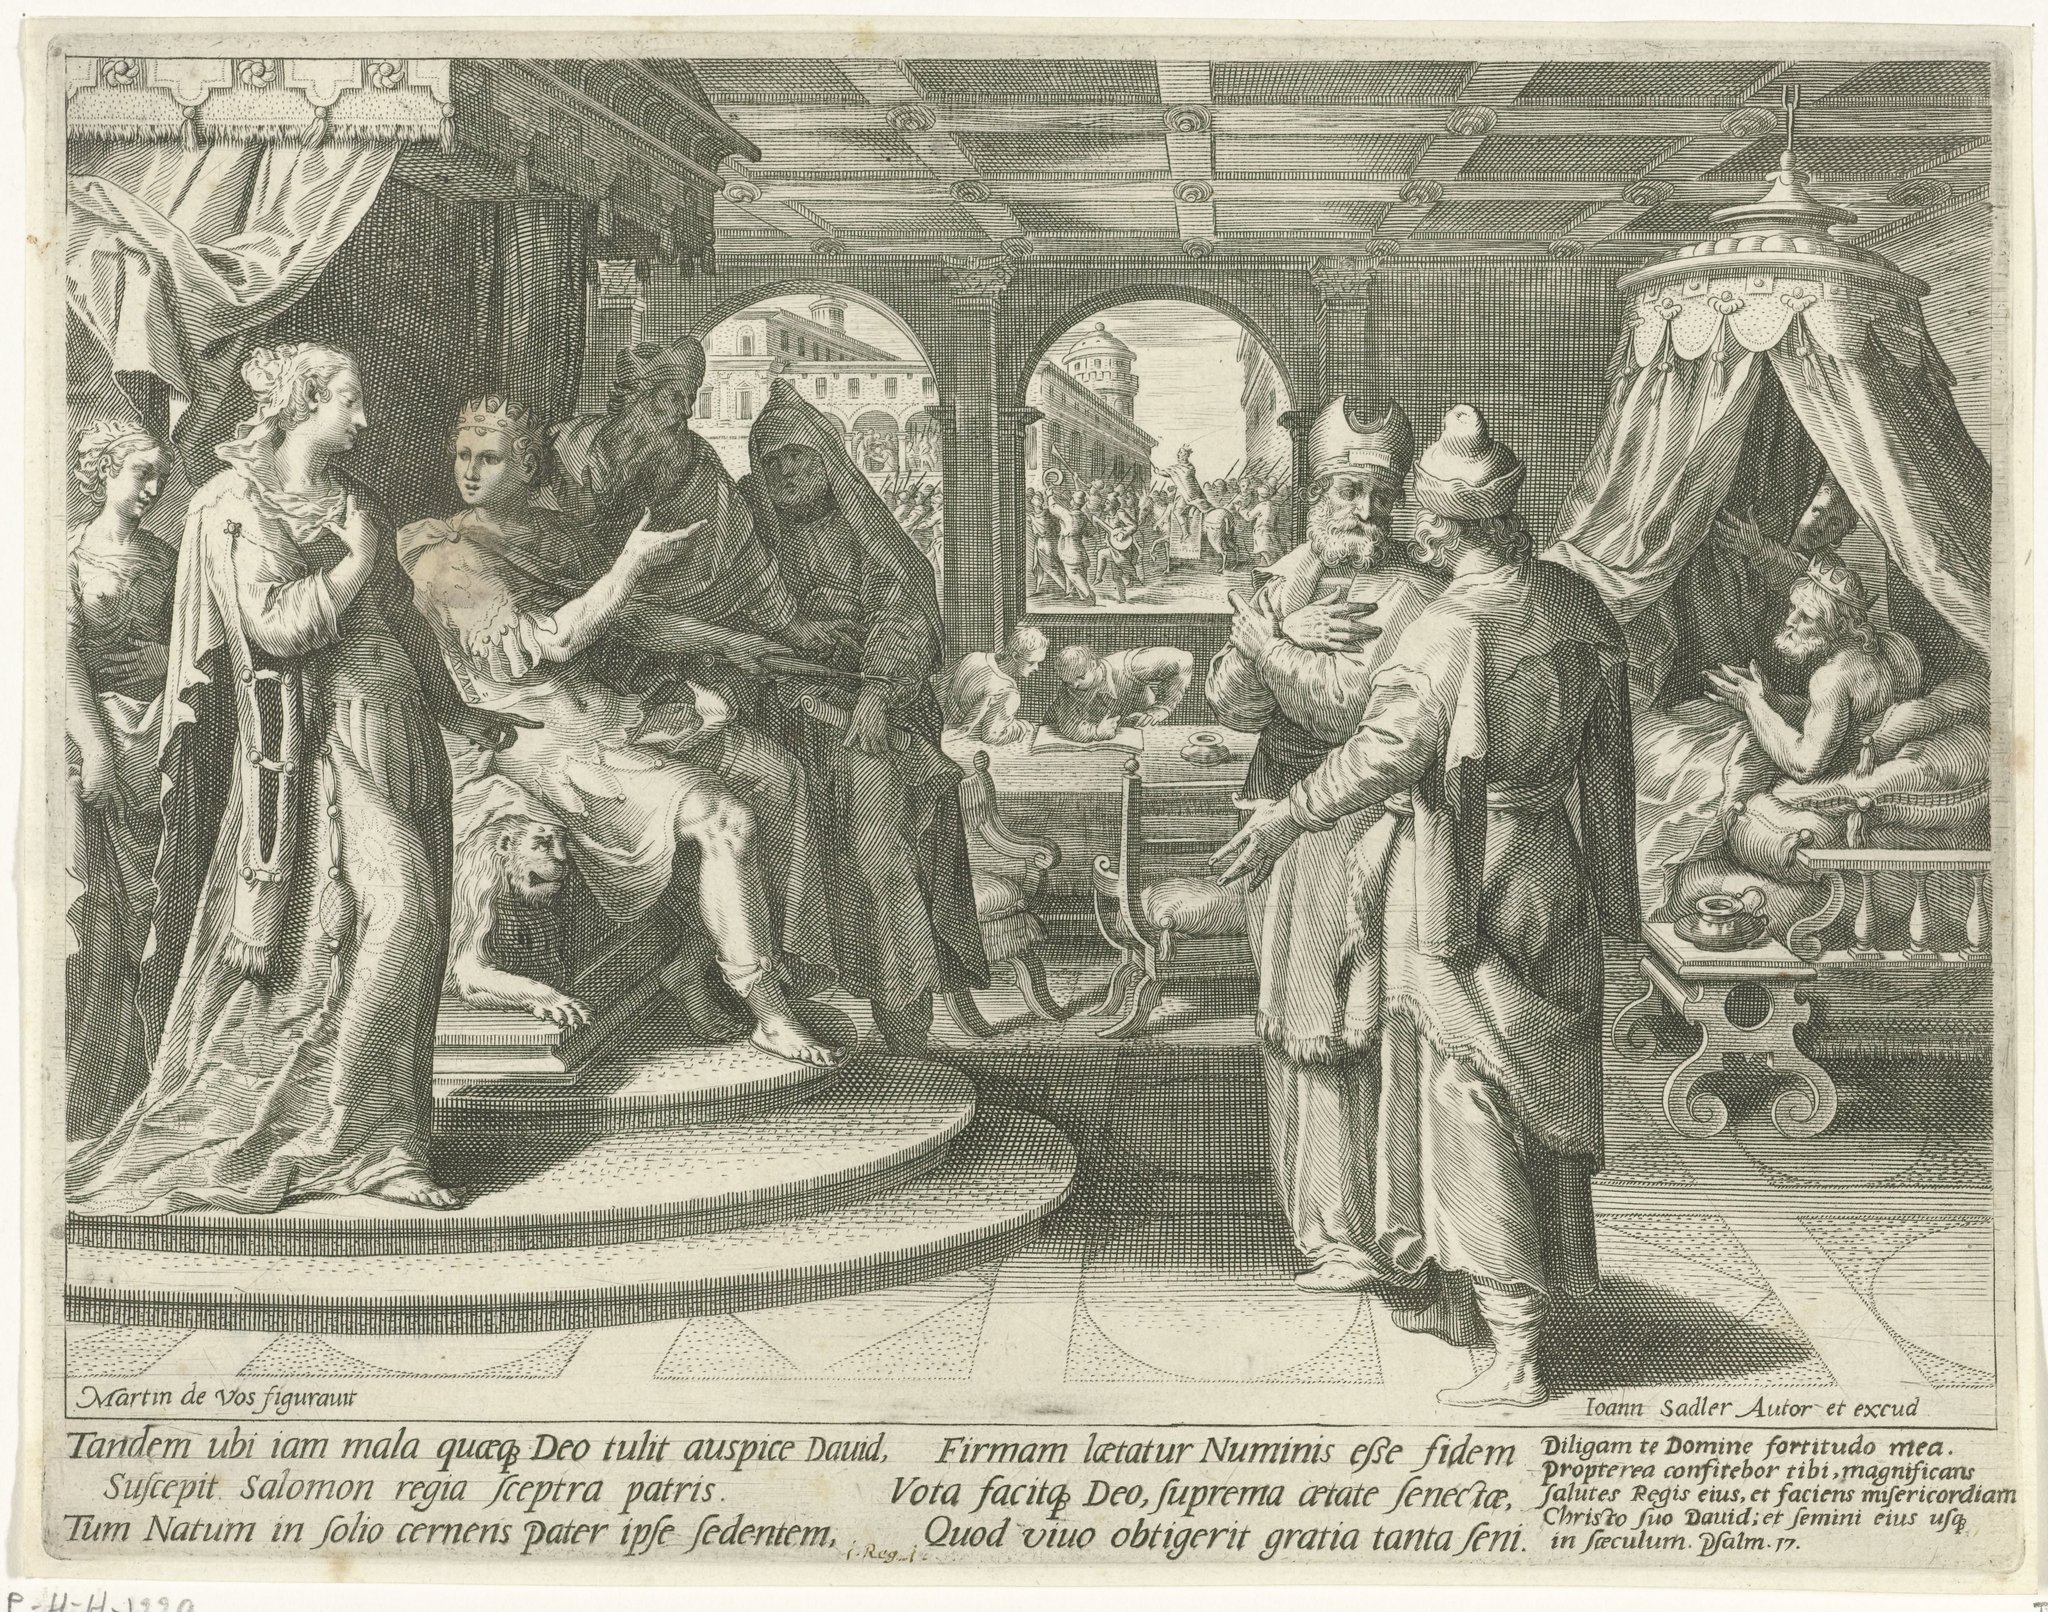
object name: print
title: Geschiedenis van David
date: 1580-1596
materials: paper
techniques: engraving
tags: solomon anointed king for the second time during a great feast; sheep and oxen are sacrificed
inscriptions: collector's mark: Lugt 11, inscription: ‘1. Reg. 1.’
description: Salomo zit op de troon en praat met zijn moeder Batseba. Rechts benoemt de stervende koning David Salomo tot zijn erfgenaam. Op de achtergrond rijdt Salomo Jeruzalem binnen op een muildier, terwijl de menigte zijn koningschap viert. De prent heeft een Latijns onderschrift met uitleg en rechts in de hoek een vers uit psalm 17.